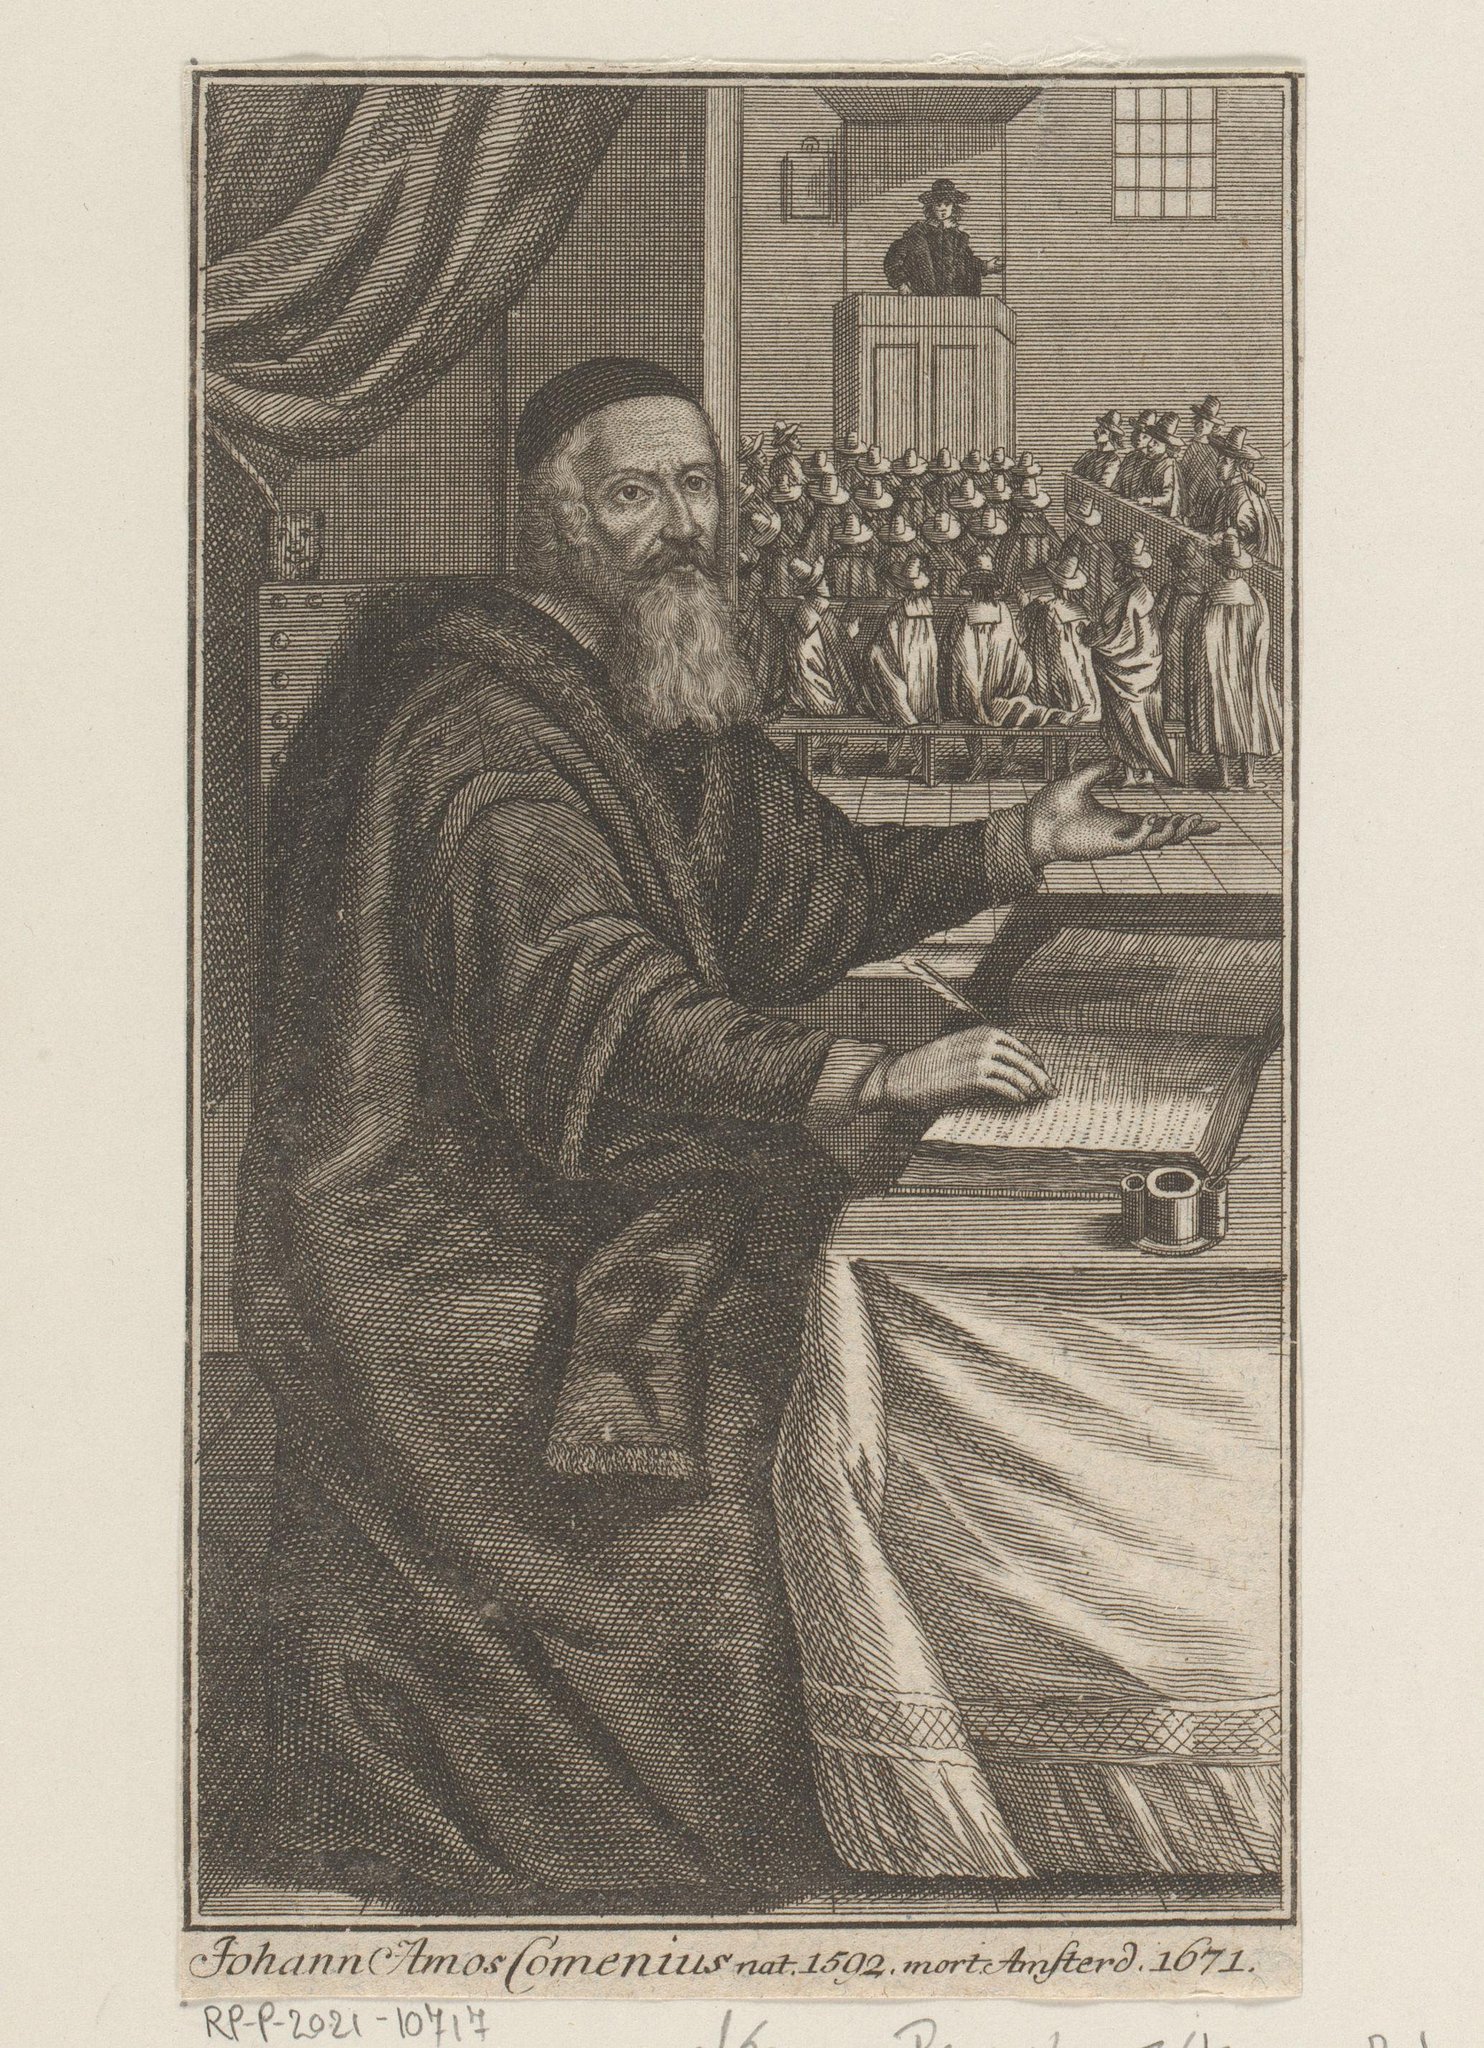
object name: print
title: Portret van Jan Amos Comenius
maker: Anonymous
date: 1671-1749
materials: paper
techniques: engraving, etching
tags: protestant churches and denominations, historical persons